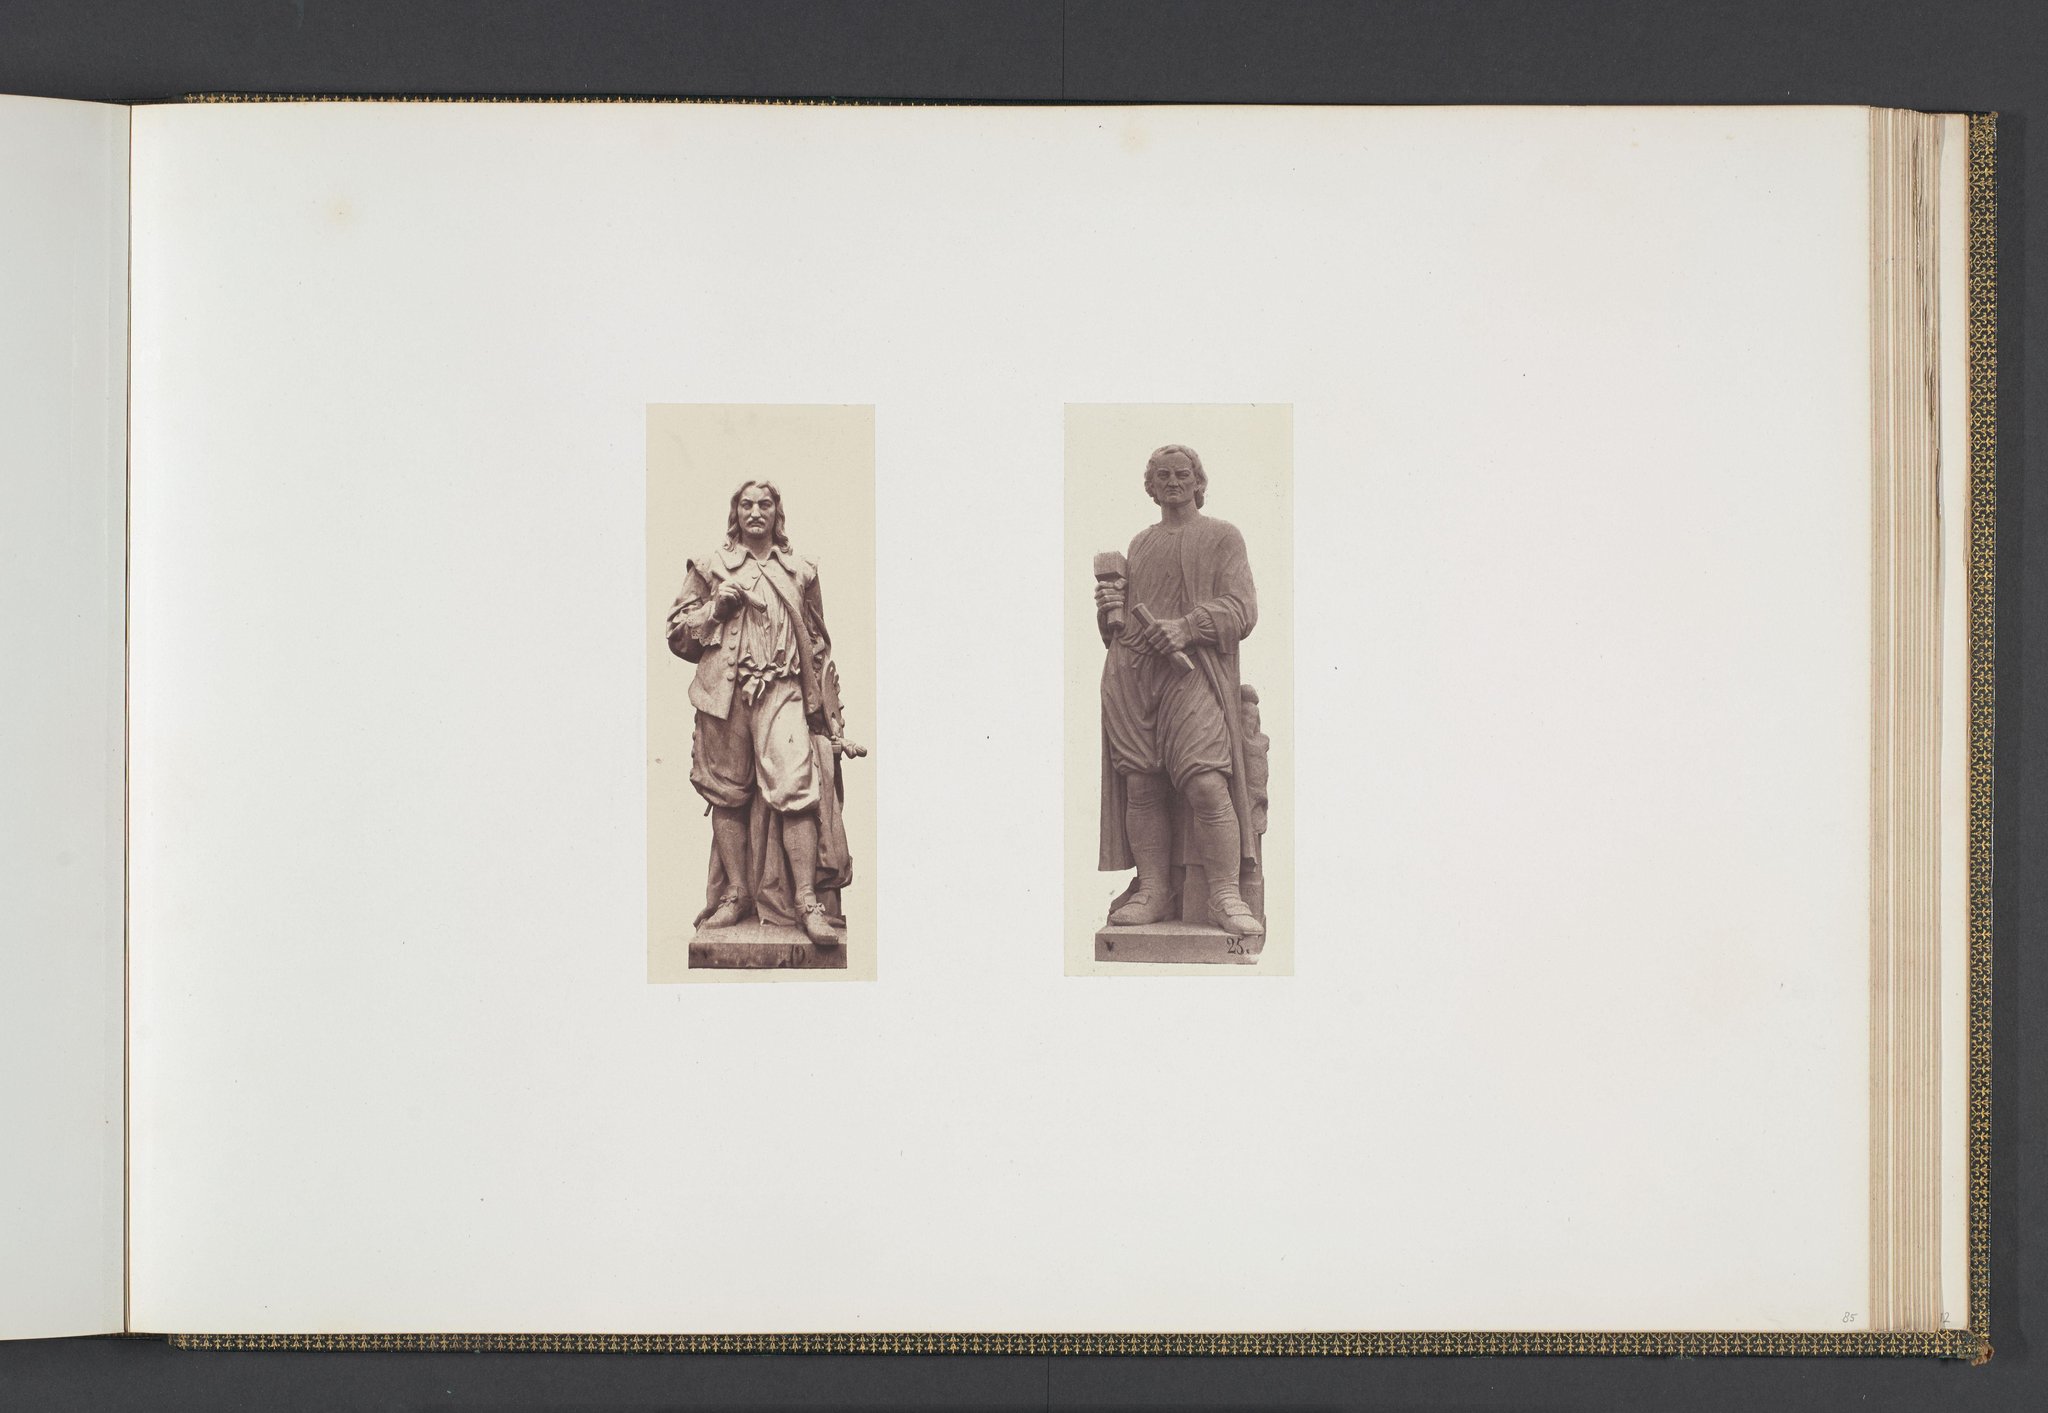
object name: album leaf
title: Gipsmodellen voor beeldhouwwerken op het Palais du Louvre: links "Champaigne" door Jean Louis Adolphe Eude en rechts "Puget" door Antoine Etex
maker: édouard denis baldus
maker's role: fotograaf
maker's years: 1813-1889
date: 1855-1857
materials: paper, photographic support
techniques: salted paper print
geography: paris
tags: piece of sculpture, reproduction of a piece of sculpture, permanent exhibition, museum, paris, tuileries palace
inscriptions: number: ‘19 en 25’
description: Onderdeel van Réunion des Tuileries au Louvre 1852-1857, album 2.